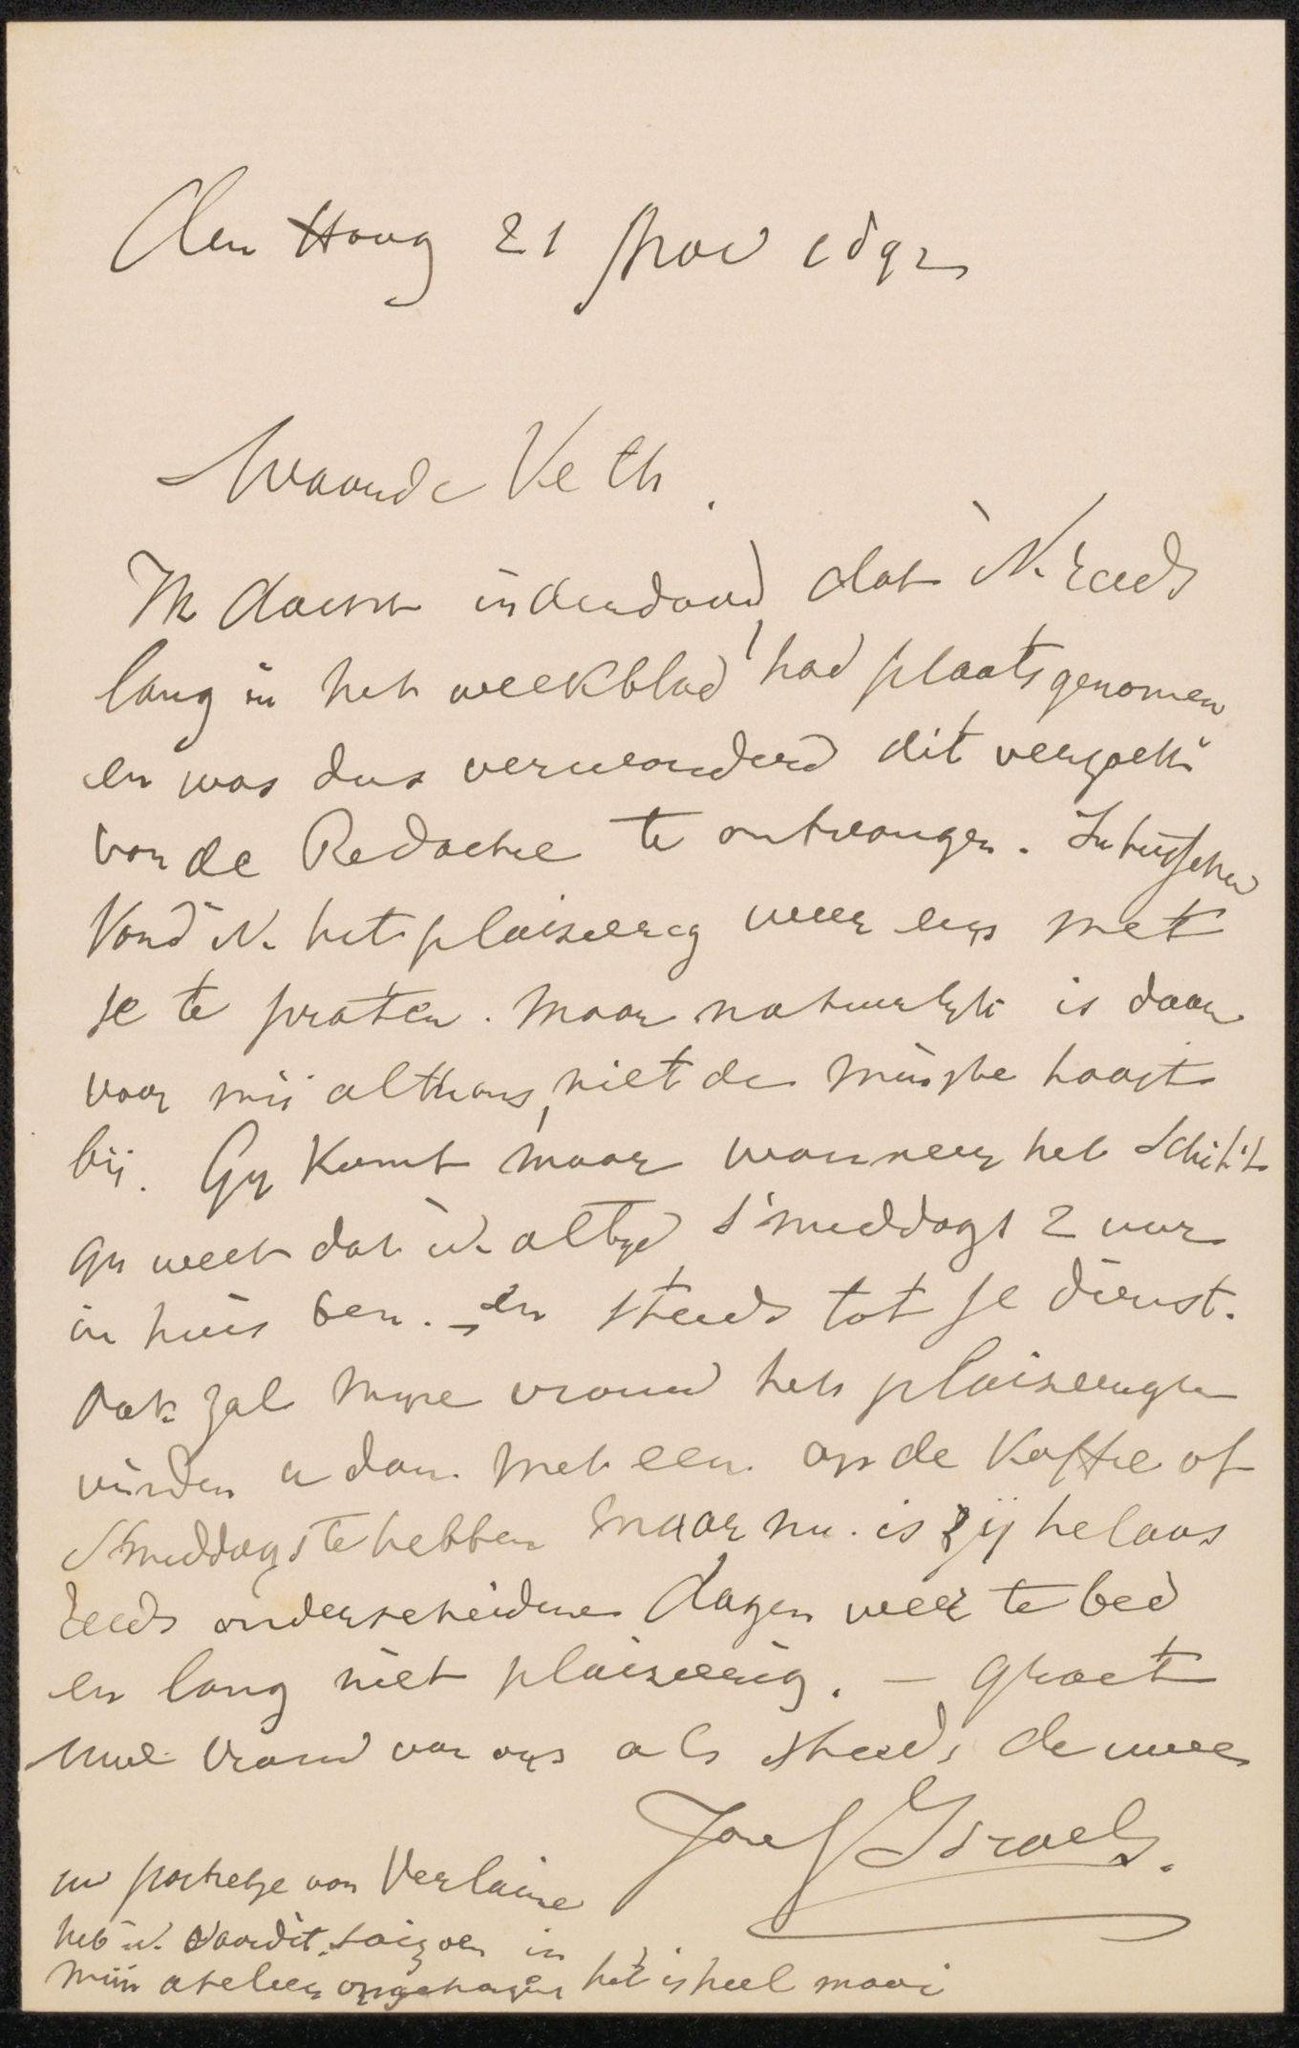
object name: letter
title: Brief aan Jan Veth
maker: jozef israëls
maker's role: draughtsman, painter, print maker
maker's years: 1824-1911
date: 1892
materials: ink, paper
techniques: pen, writing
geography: the hague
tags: dordrecht, painter, print maker, draughtsman, designer, jan veth, paul verlaine, workshop, studio of the artist (in general), diseases, historical persons (portraits and scenes from the life)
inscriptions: collector's mark: ‘RPK’